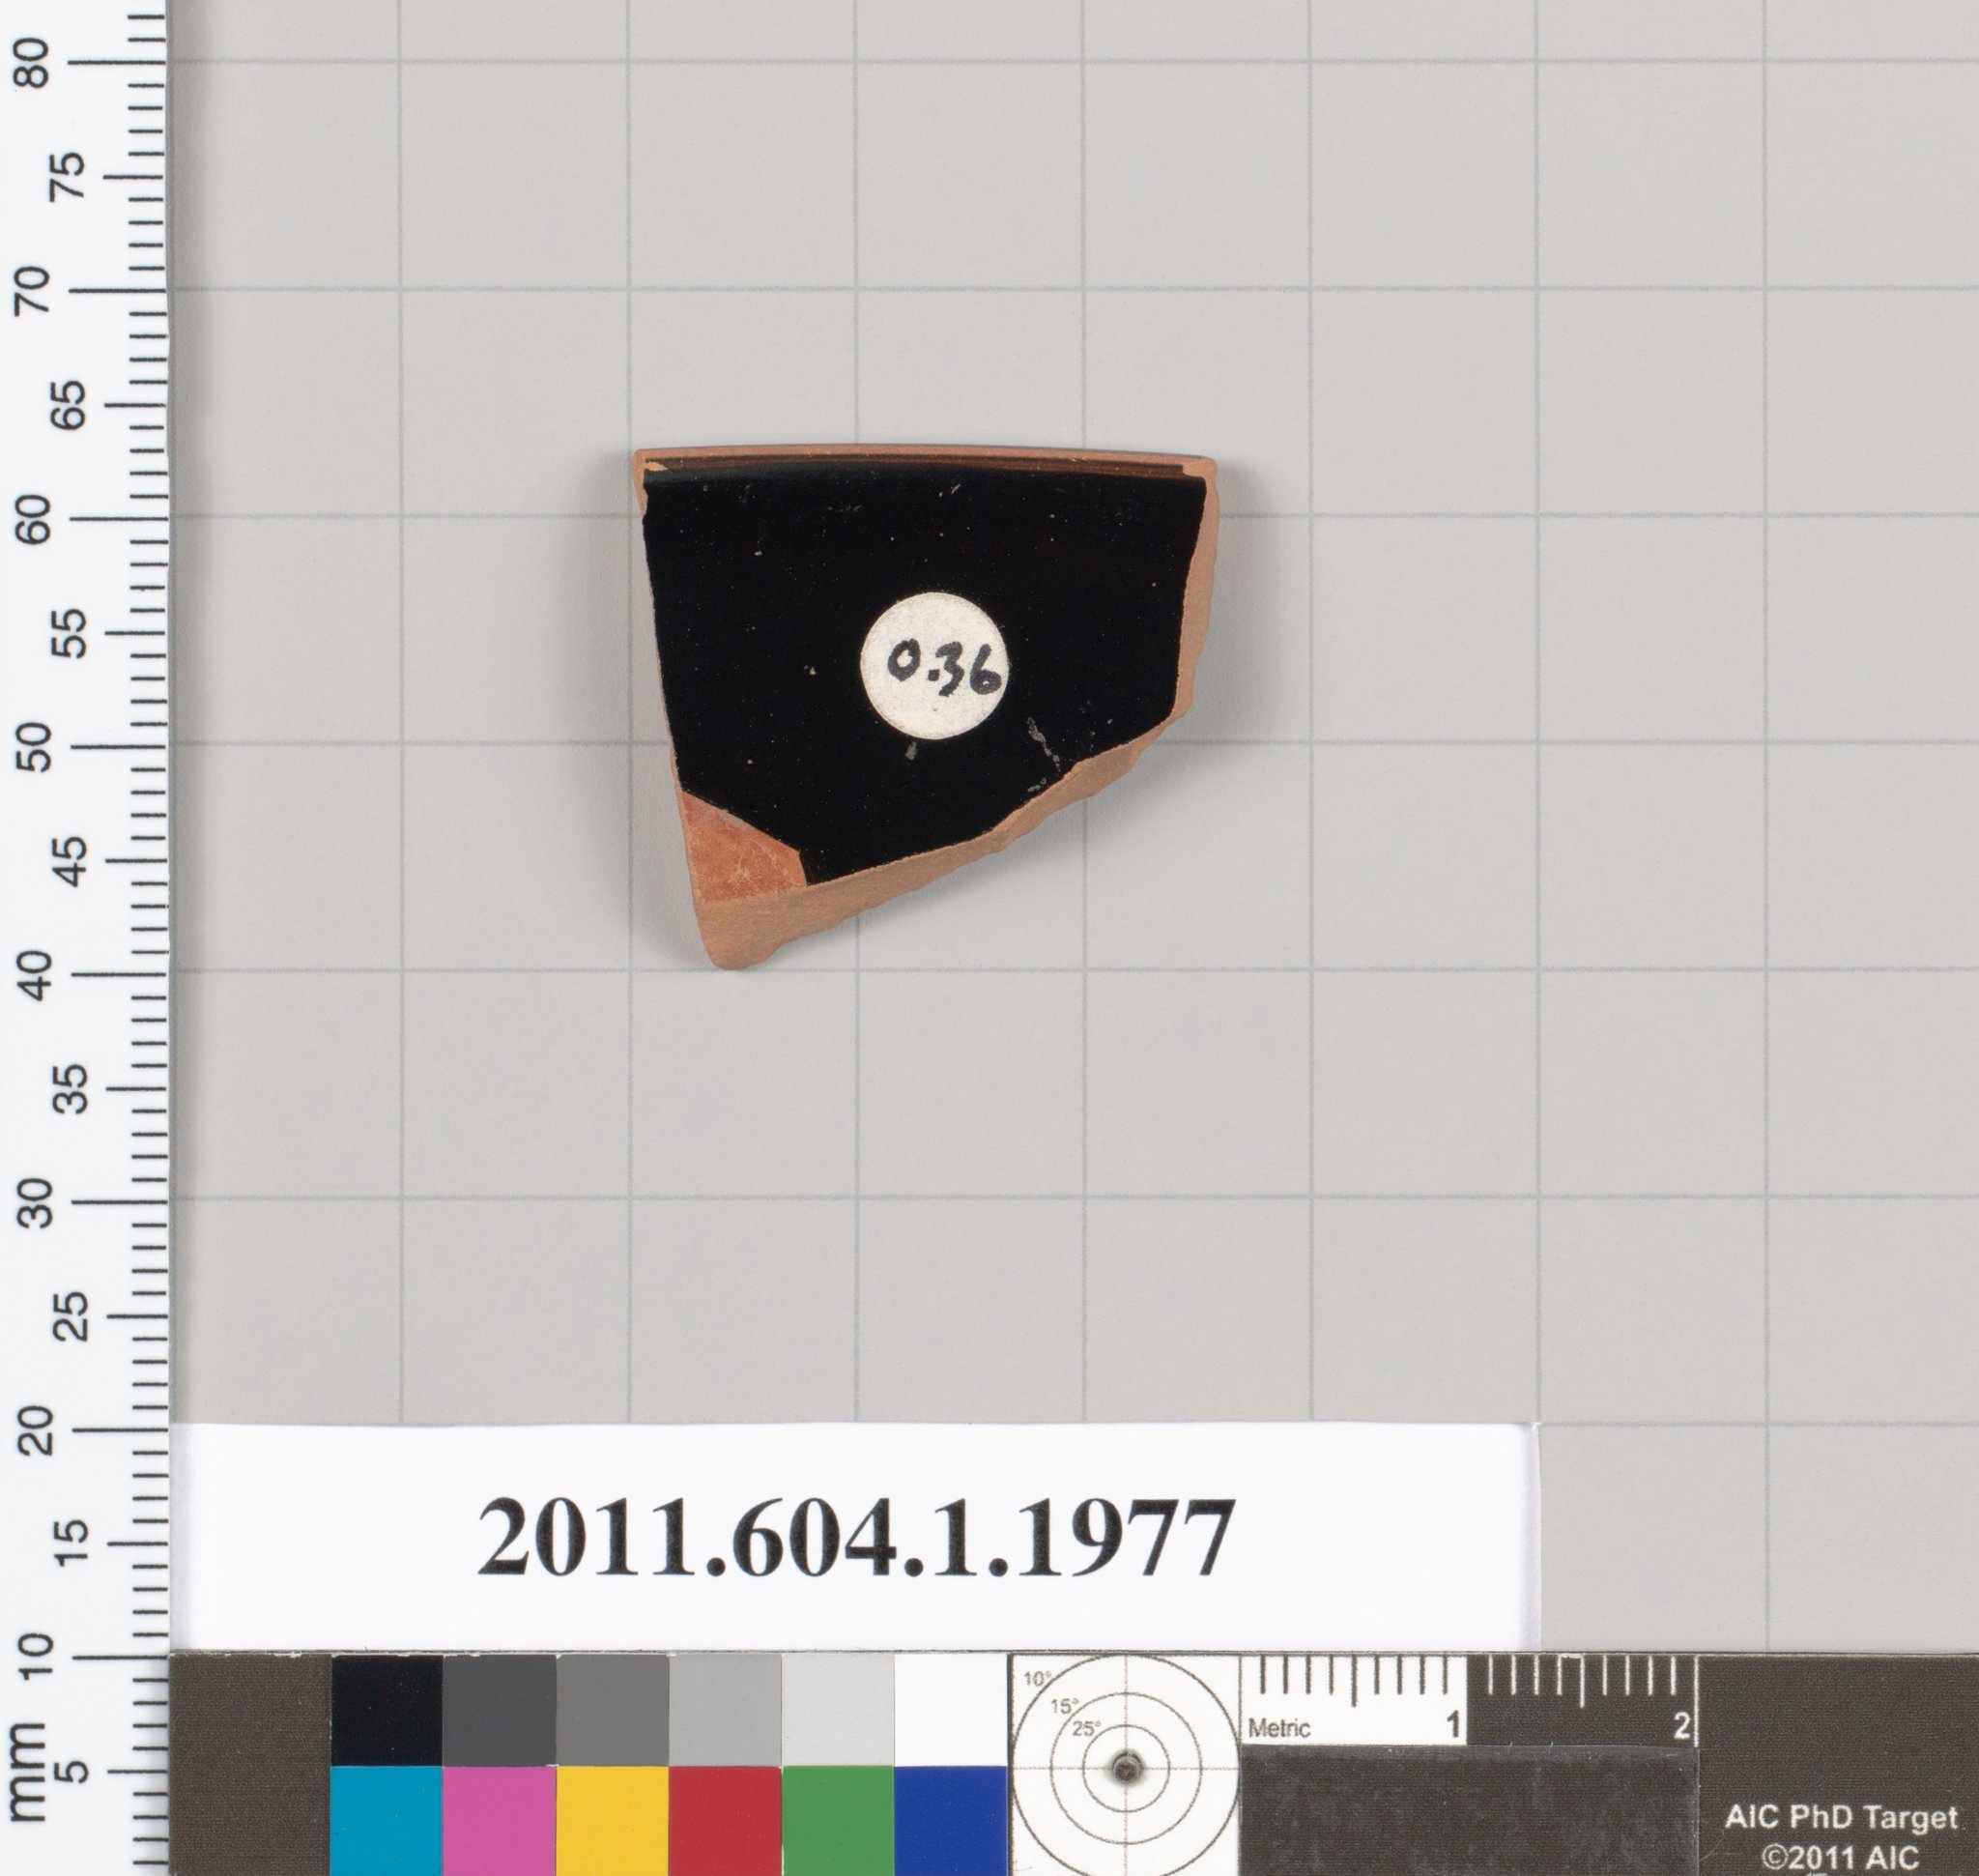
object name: kylix fragment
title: Terracotta rim fragment of a kylix (drinking cup)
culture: greek, attic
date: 500-401 BCE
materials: terracotta